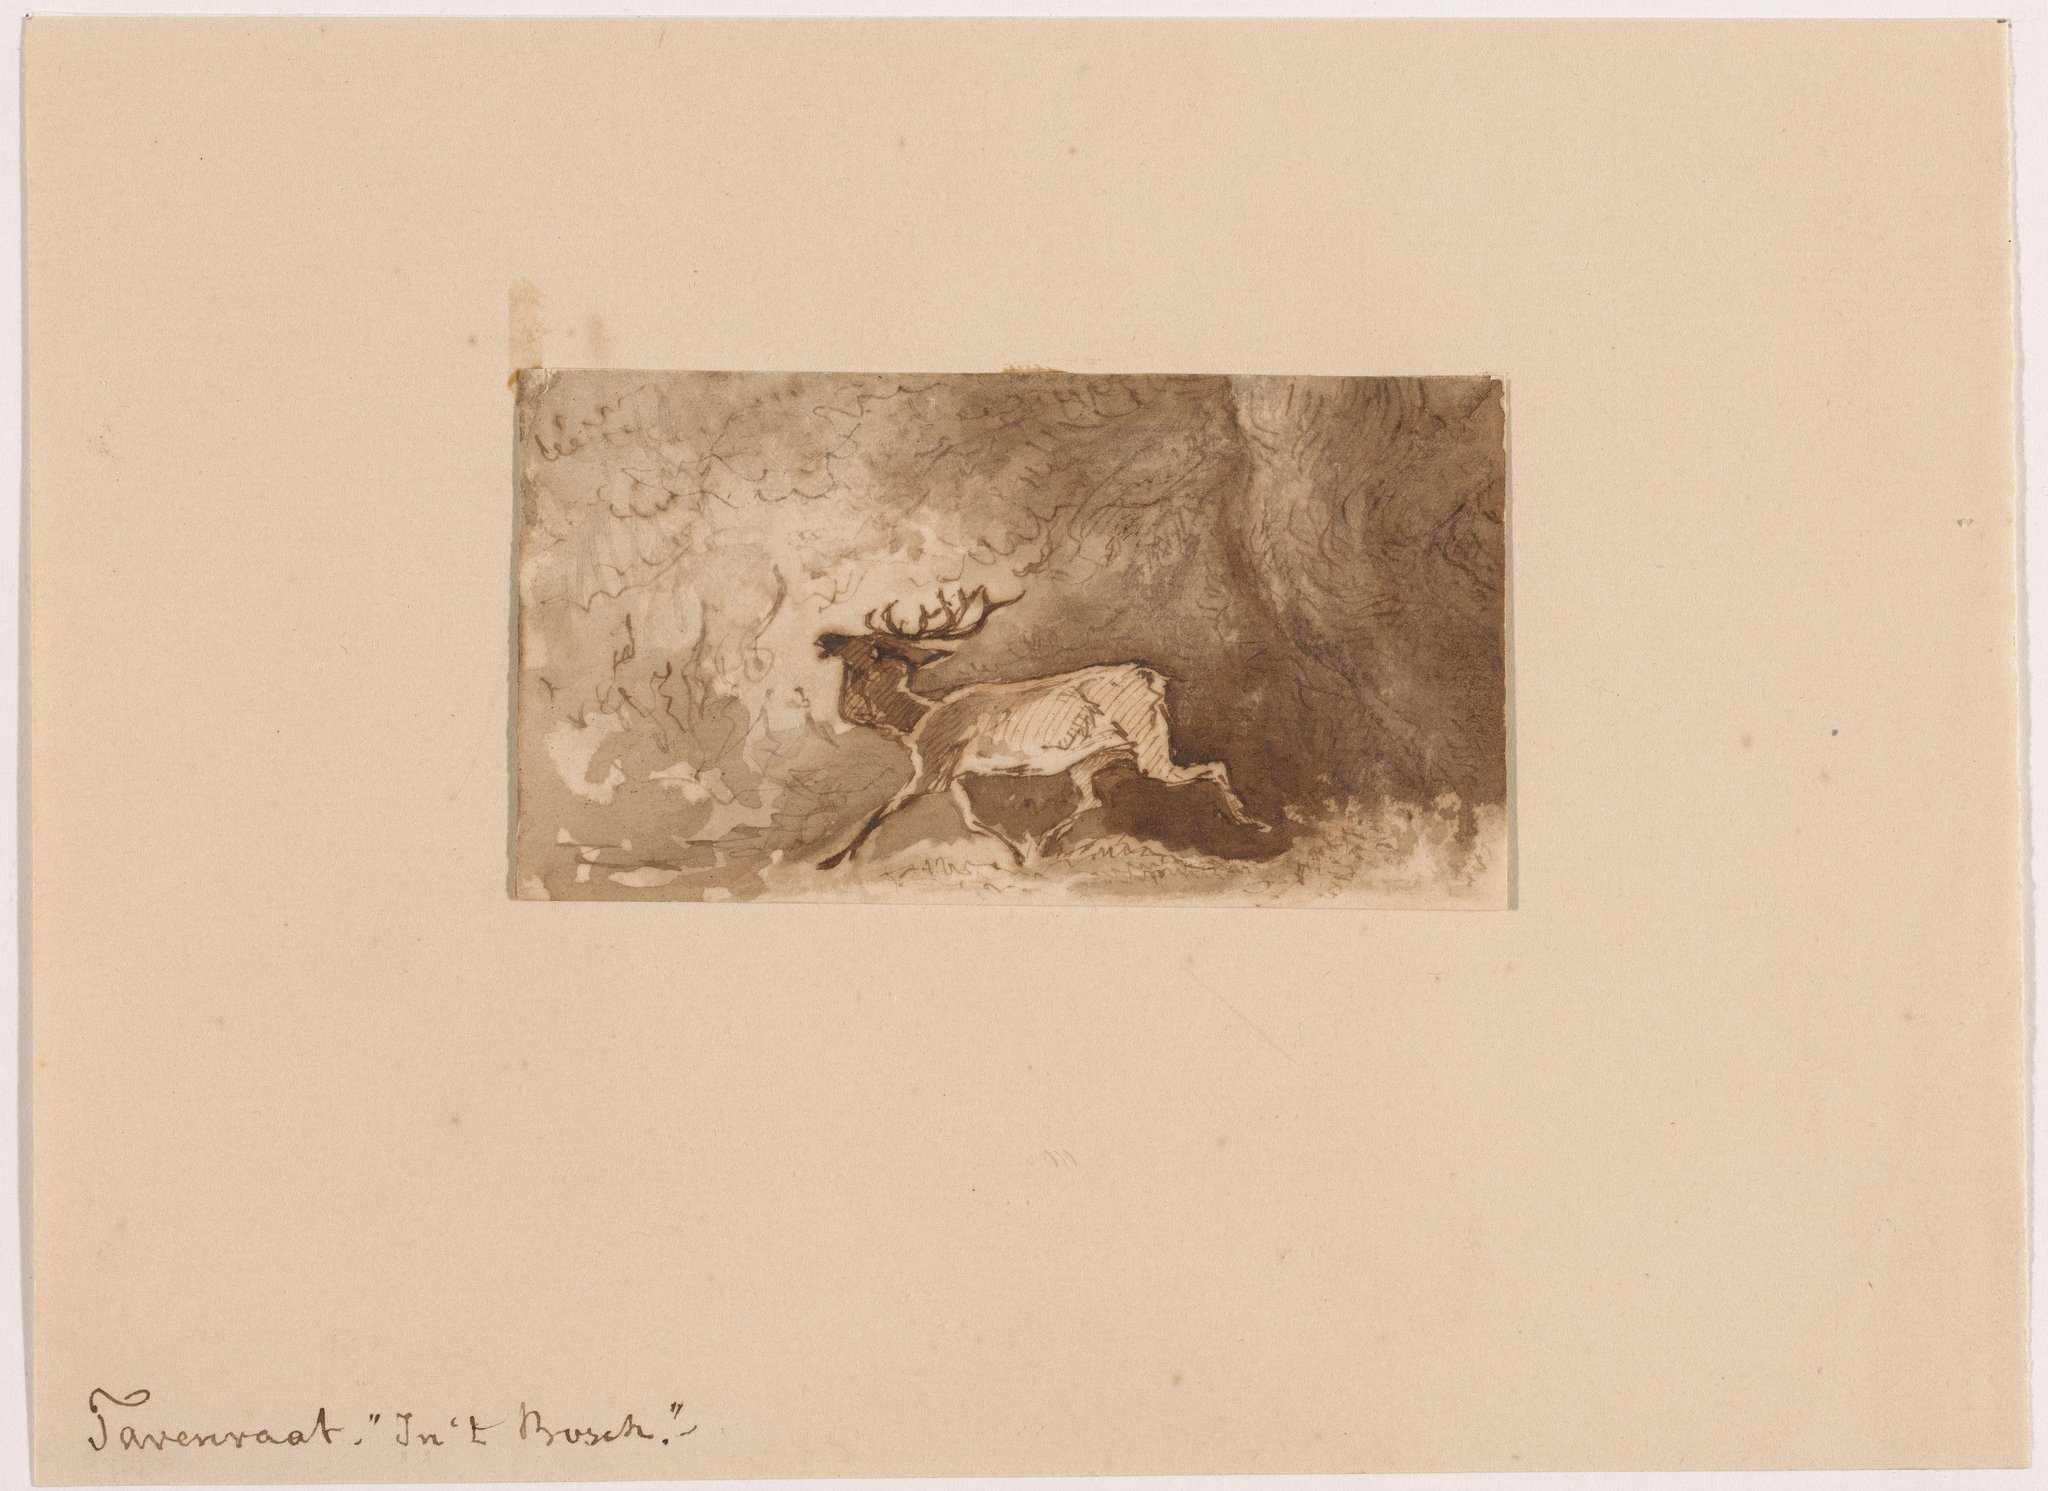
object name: drawing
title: In 't Bosch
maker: johannes tavenraat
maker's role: draughtsman, painter, print maker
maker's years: 1809-1881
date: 1840-1870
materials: ink, paper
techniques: brush, pen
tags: hoofed animals: deer, forest, wood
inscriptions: signature: ‘Tavenraat’, annotation: ‘Tavenraat. "In 't Bosch."’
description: Hert in het bos. Op de achterzijde een schets van een vos.